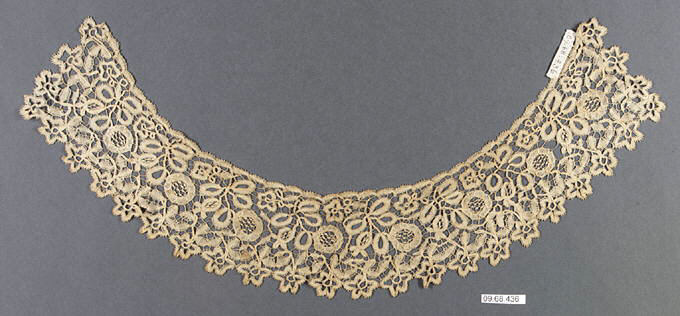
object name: collar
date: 1801-1900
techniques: lace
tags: flowers